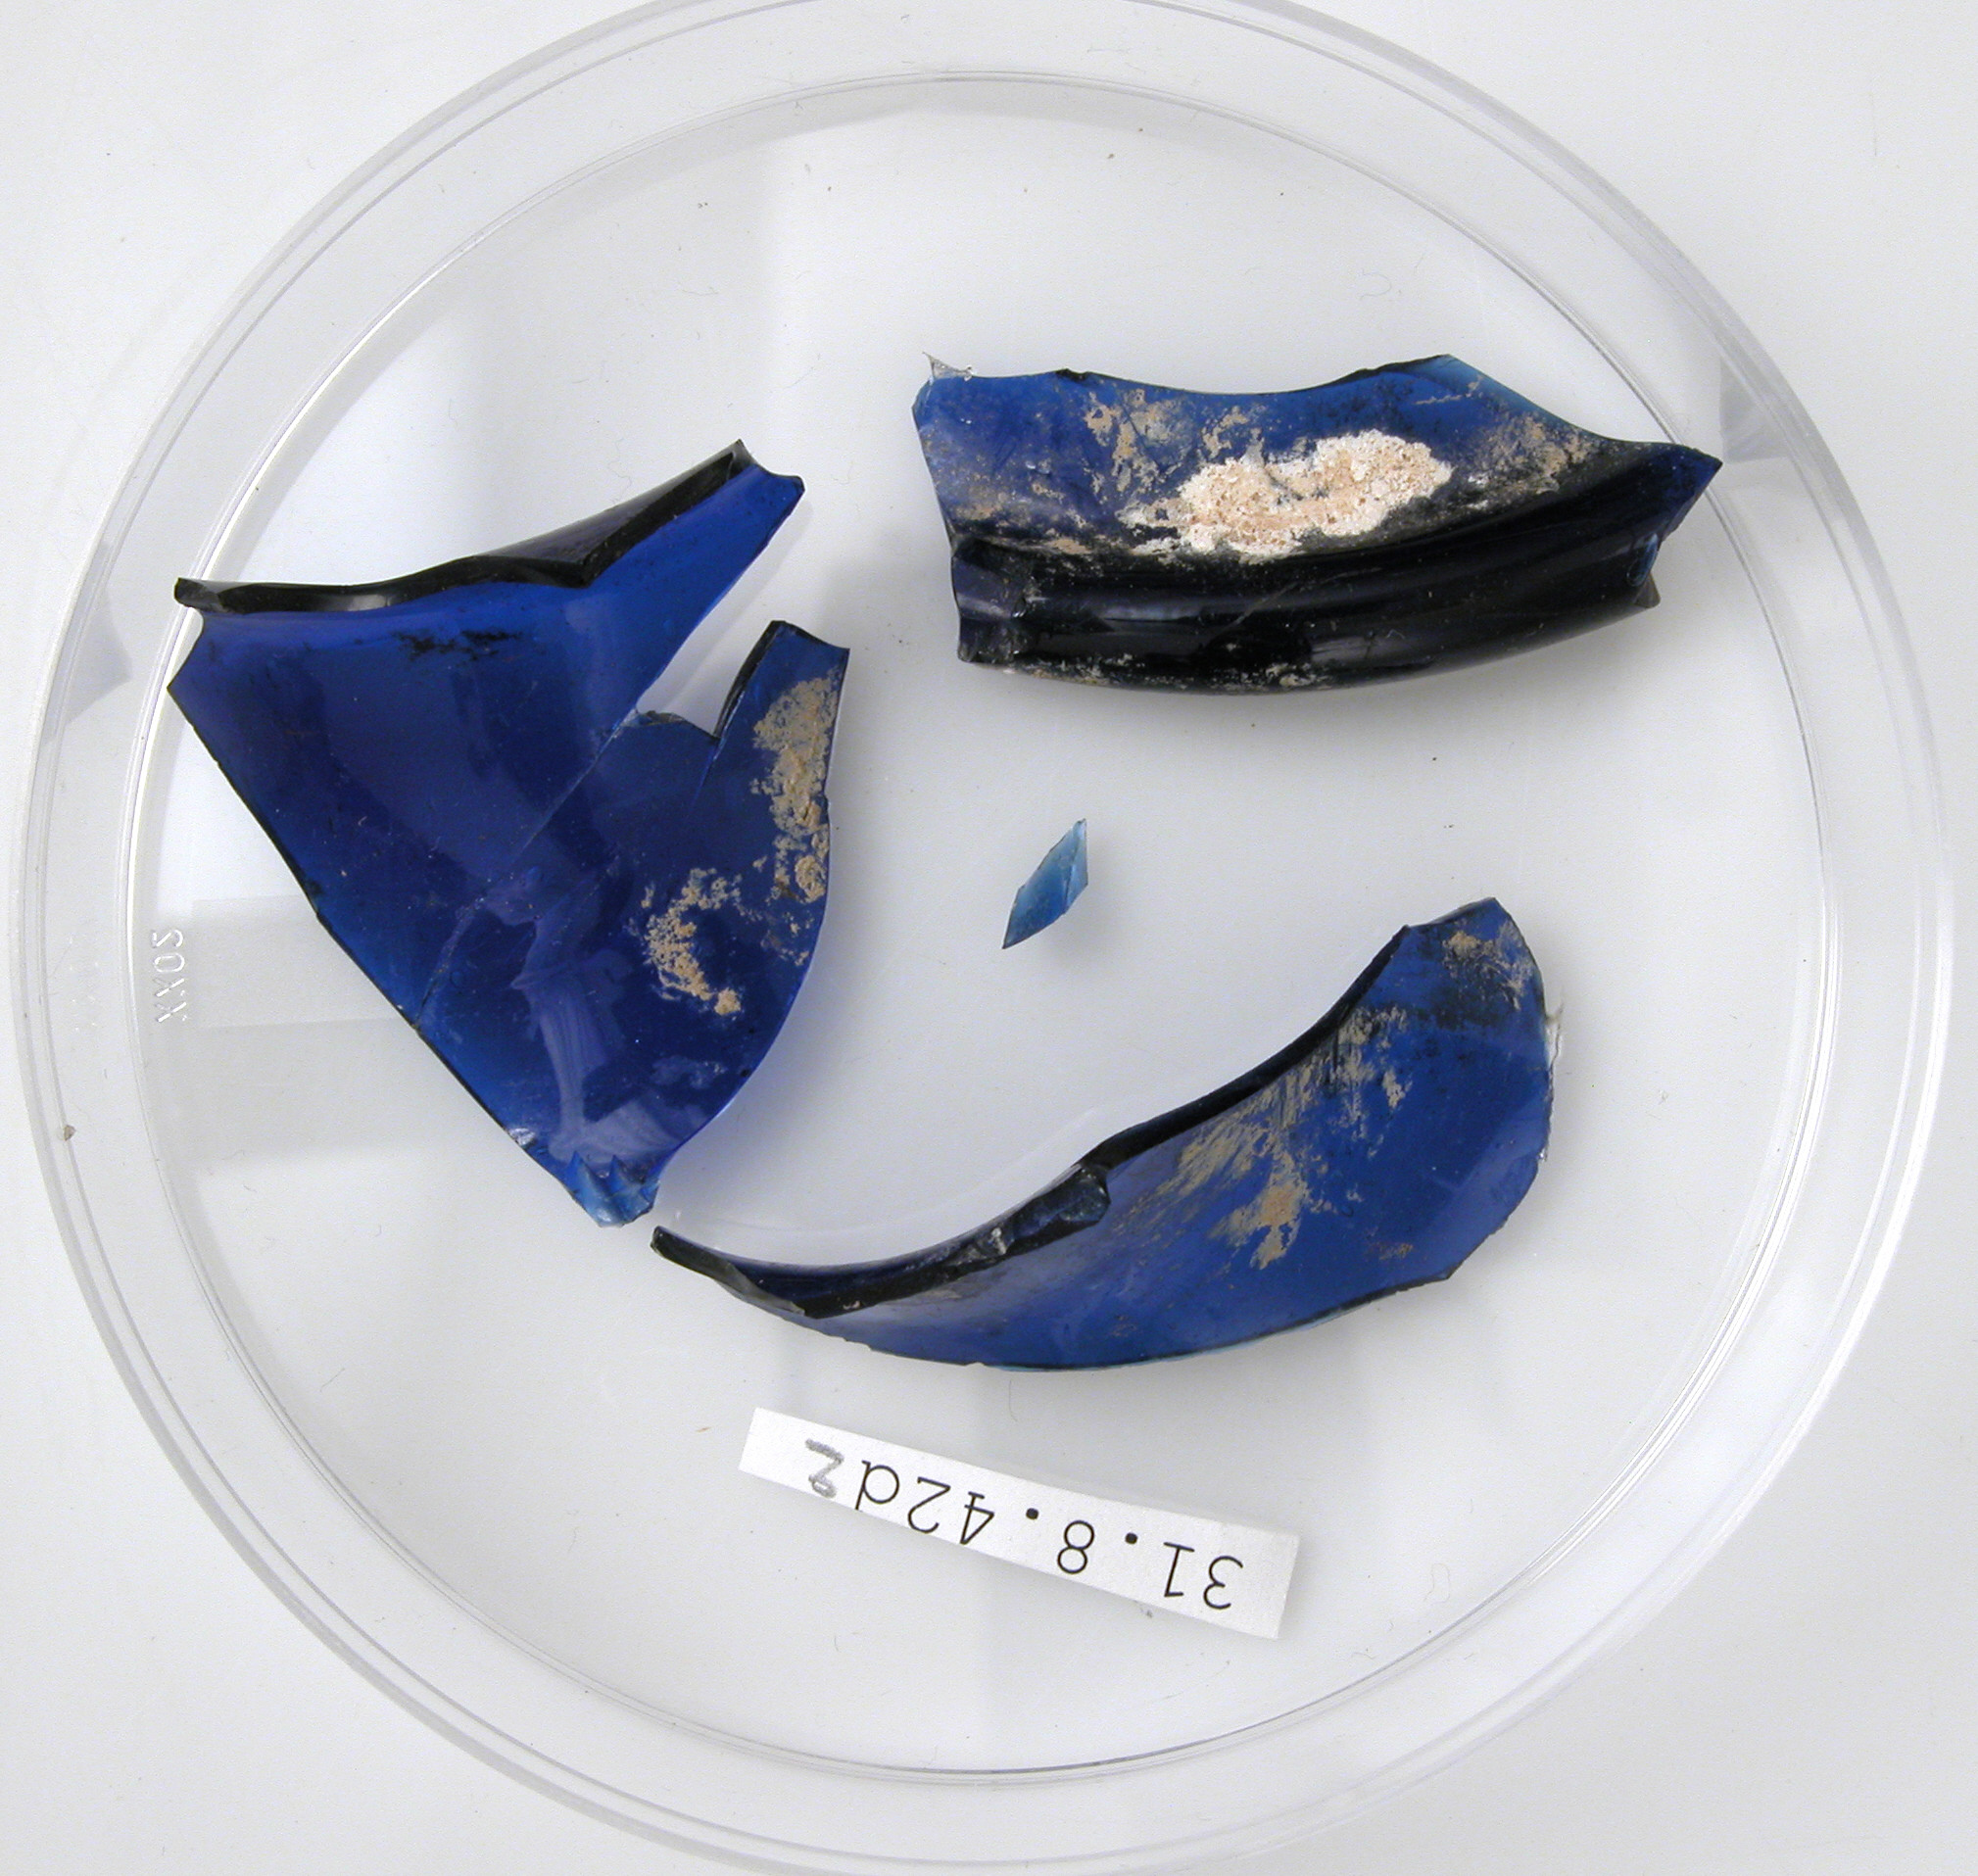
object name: fragment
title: Glass Fragments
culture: coptic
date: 301-400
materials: glass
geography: egypt